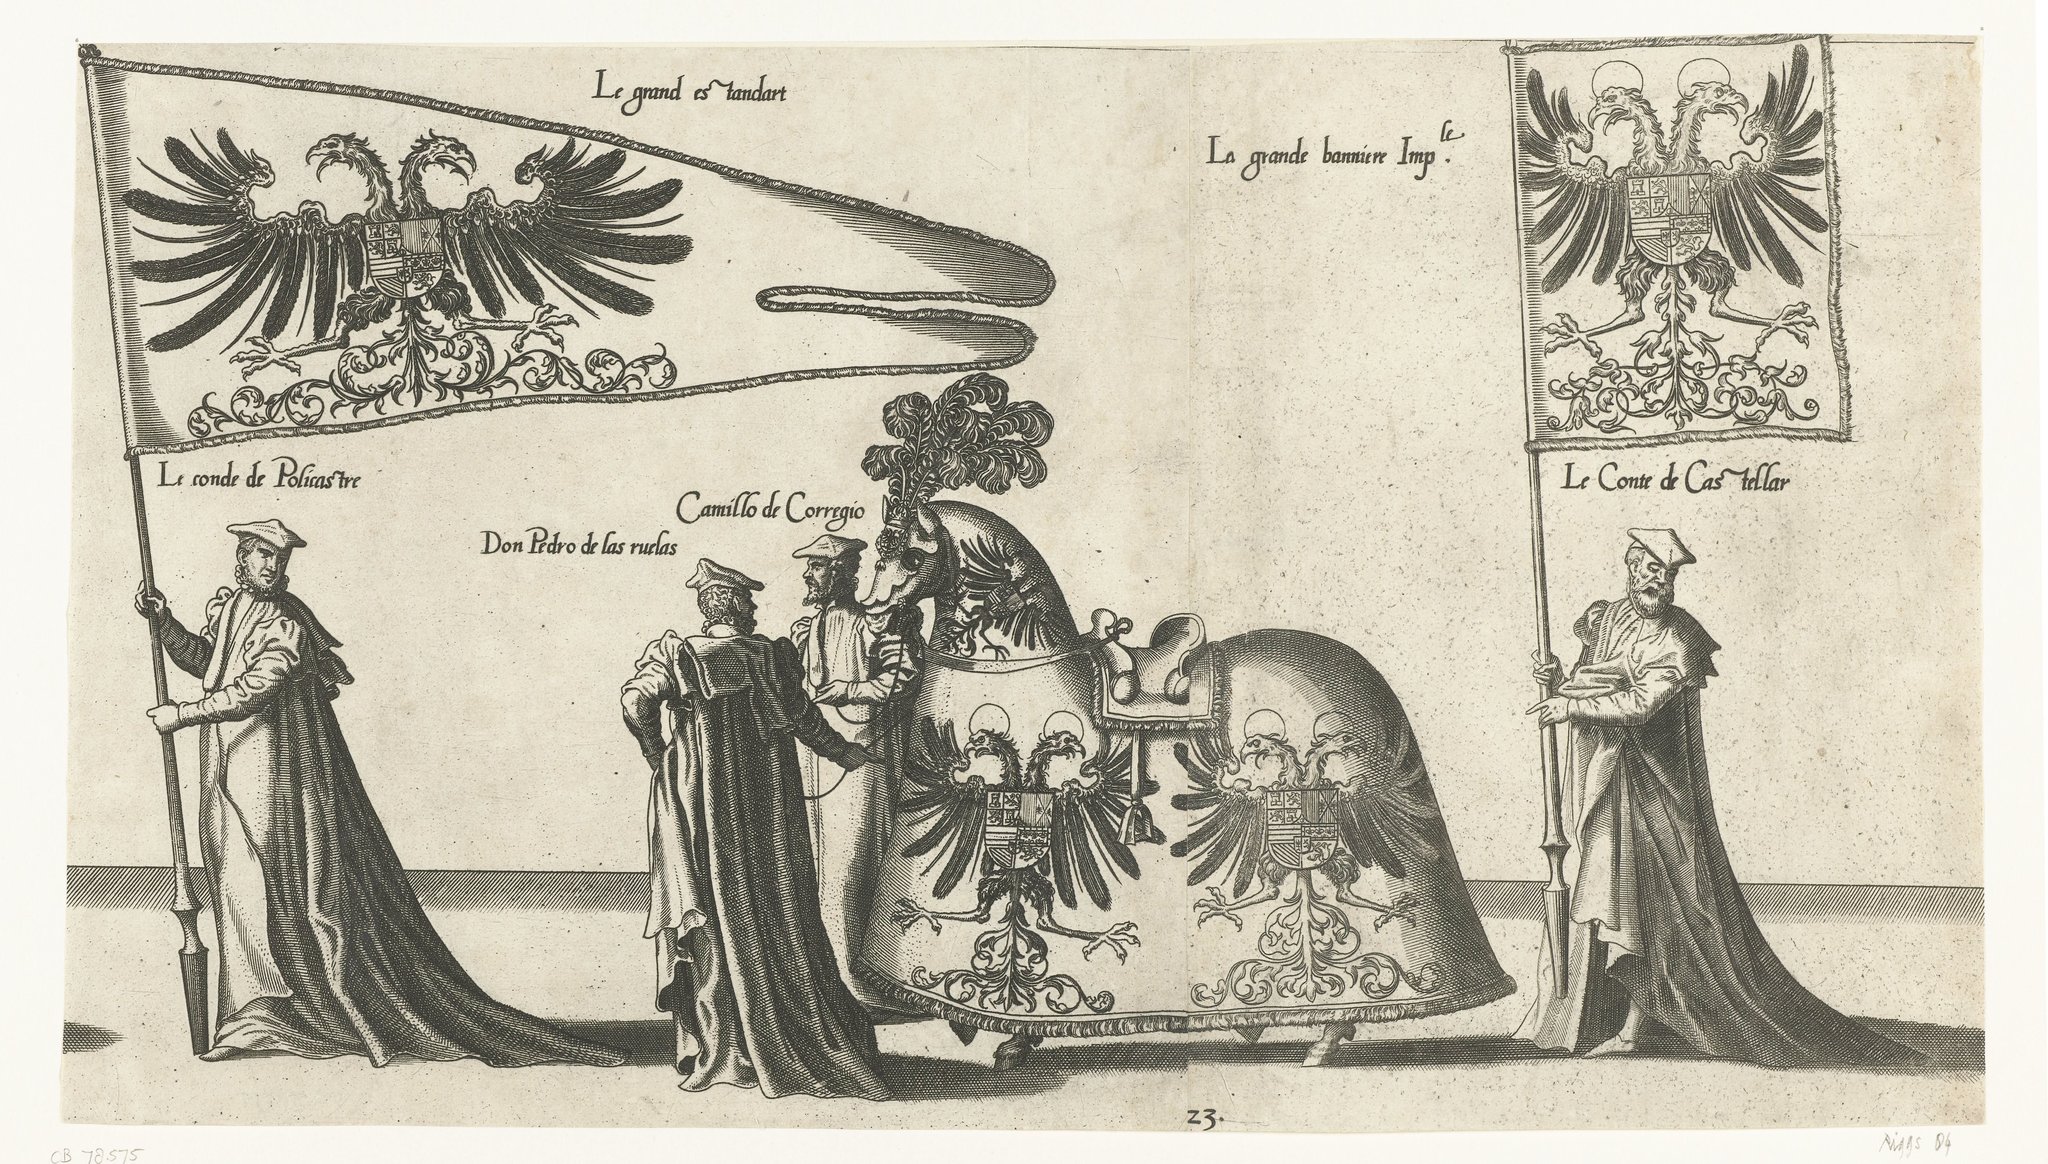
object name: print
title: Deel van de optocht, nr. 22-23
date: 1559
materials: paper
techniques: engraving, etching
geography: southern netherlands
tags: ghent, charles v (holy roman emperor and king of spain), cortege, funeral procession, brussels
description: Vier deelnemers aan de optocht, een paard en de keizerlijke vaandels. Onderdeel van de prentreeks van de Begrafenisoptocht van keizer Karel V op 29 december 1558 te Brussel. Prent nr. 22 is aan prent nr. 23 vastgeplakt.